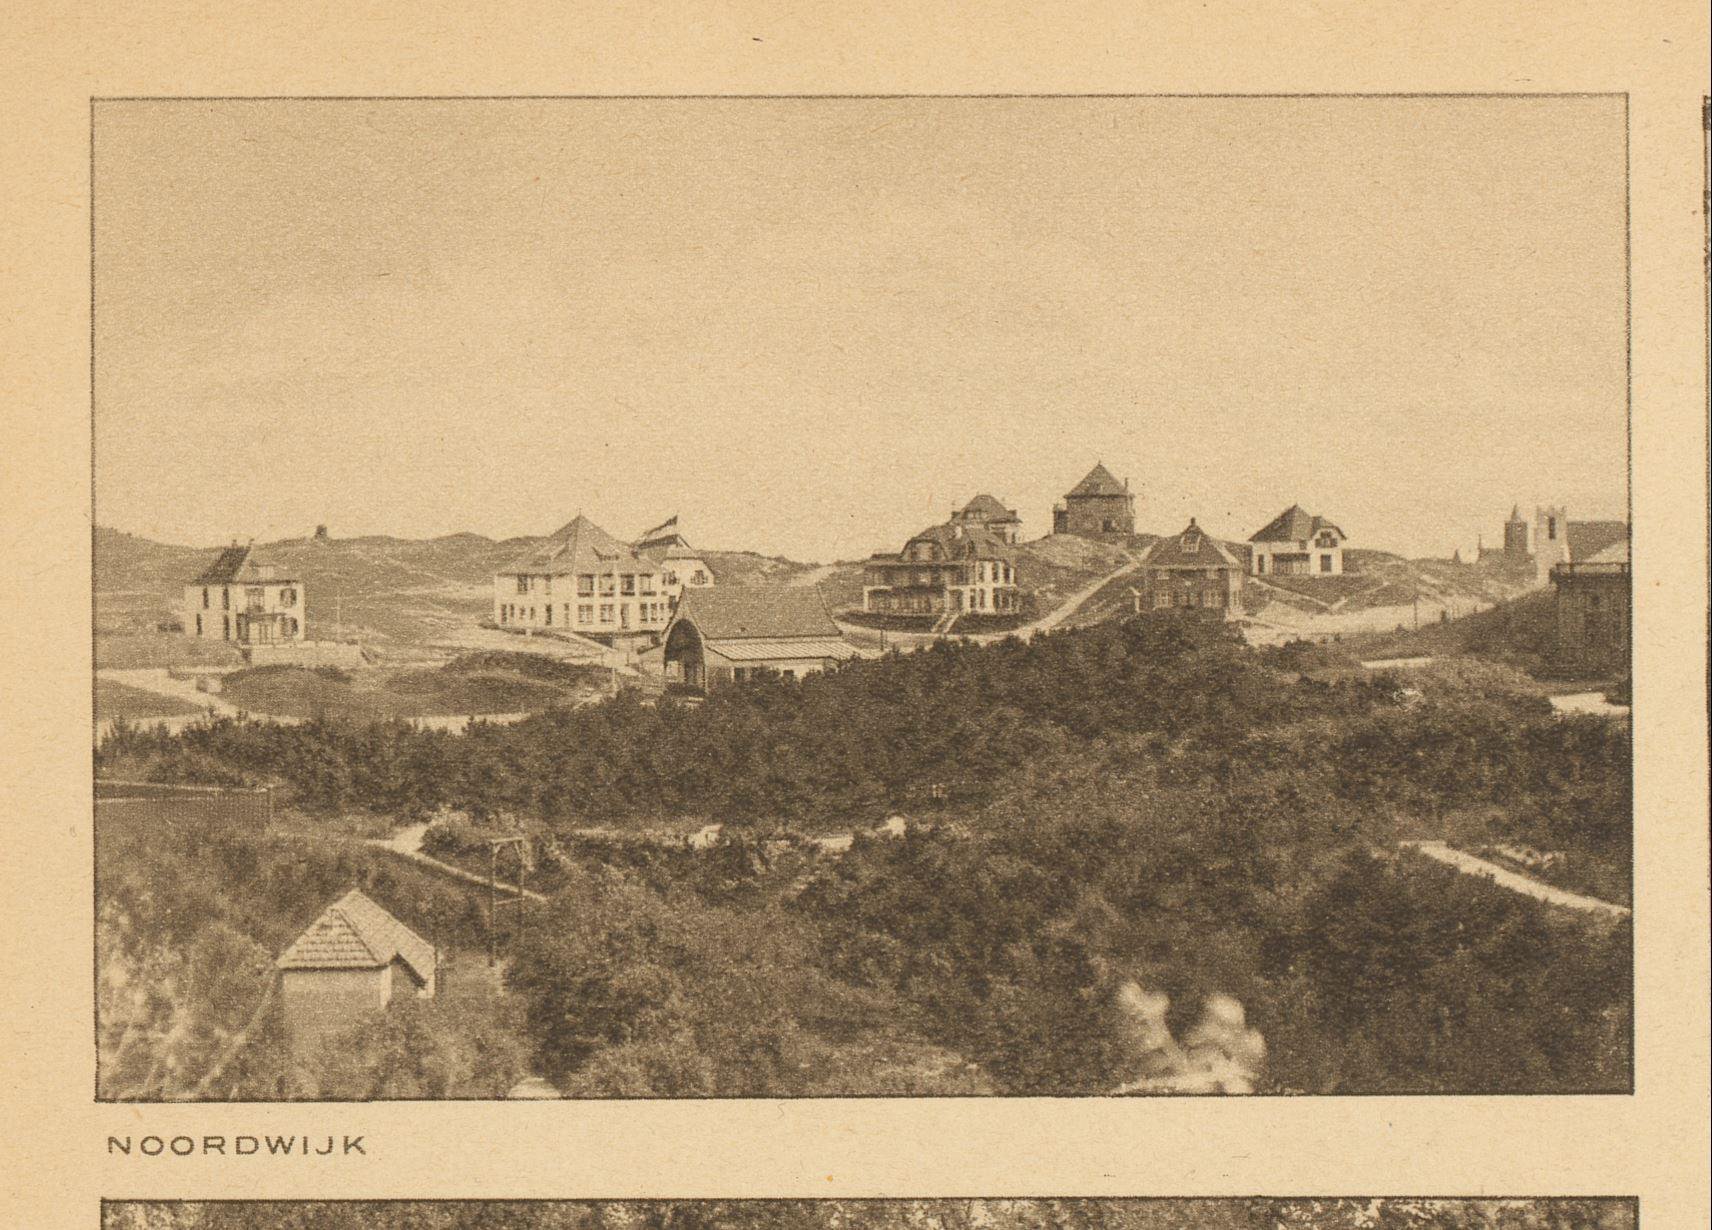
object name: photomechanical print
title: Noordwijk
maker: Anonymous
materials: paper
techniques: rotogravure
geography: noordwijk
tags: prospect of village, silhouette of village, dunes (sea not visible); in the dunes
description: Deze prent maakt deel uit van een album.